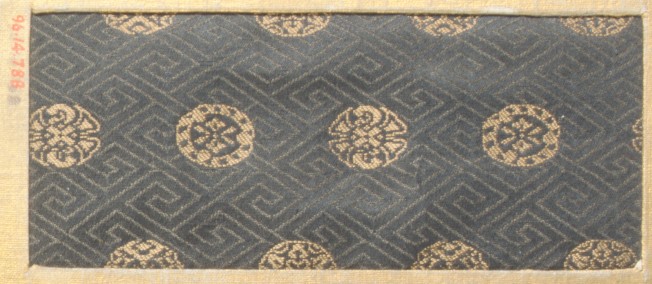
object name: piece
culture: japanese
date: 1701-1900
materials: silk